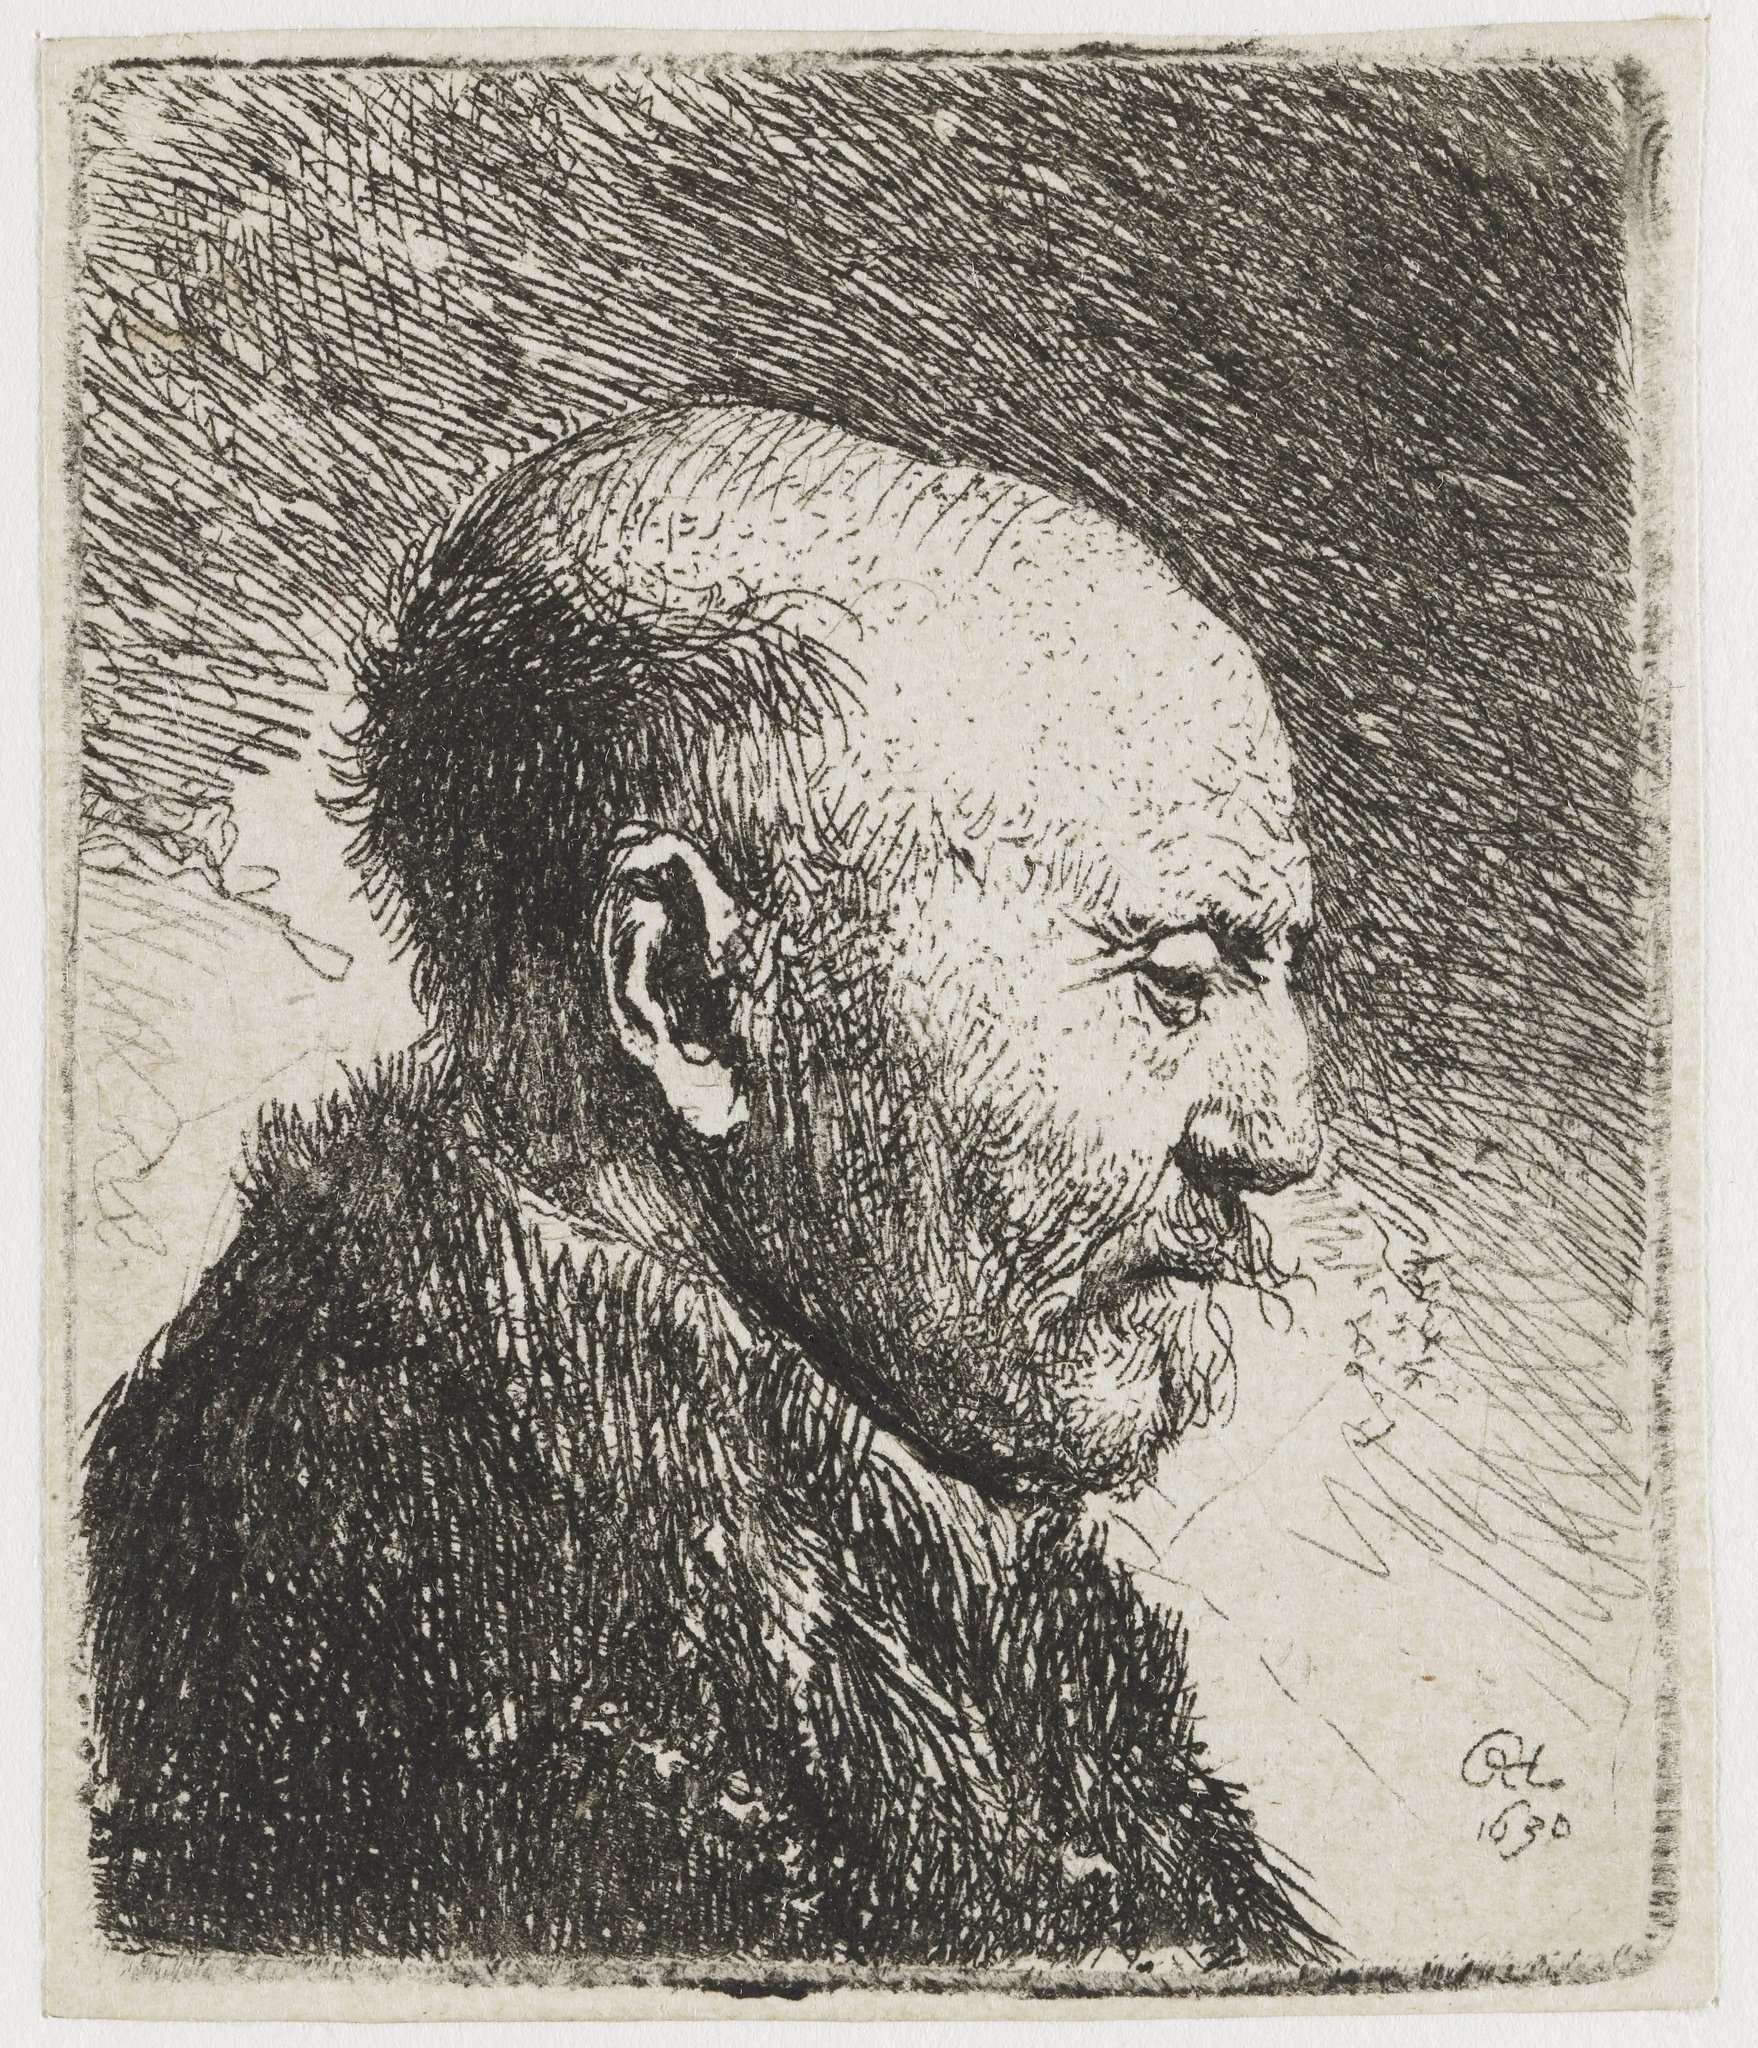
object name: print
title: Bald headed man in profile right: the artist's father (?)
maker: rembrandt van rijn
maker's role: draughtsman, painter, print maker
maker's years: 1606-1669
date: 1630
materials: paper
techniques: etching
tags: leiden, can hook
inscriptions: collector's mark: Lugt 2228, monogram and date: ‘RHL 1630’, mark: Lugt 174, inscription: ‘Deux tetes d'Homes... No 270 (Gersaint nummer)’, inscription: ‘C. 15150’